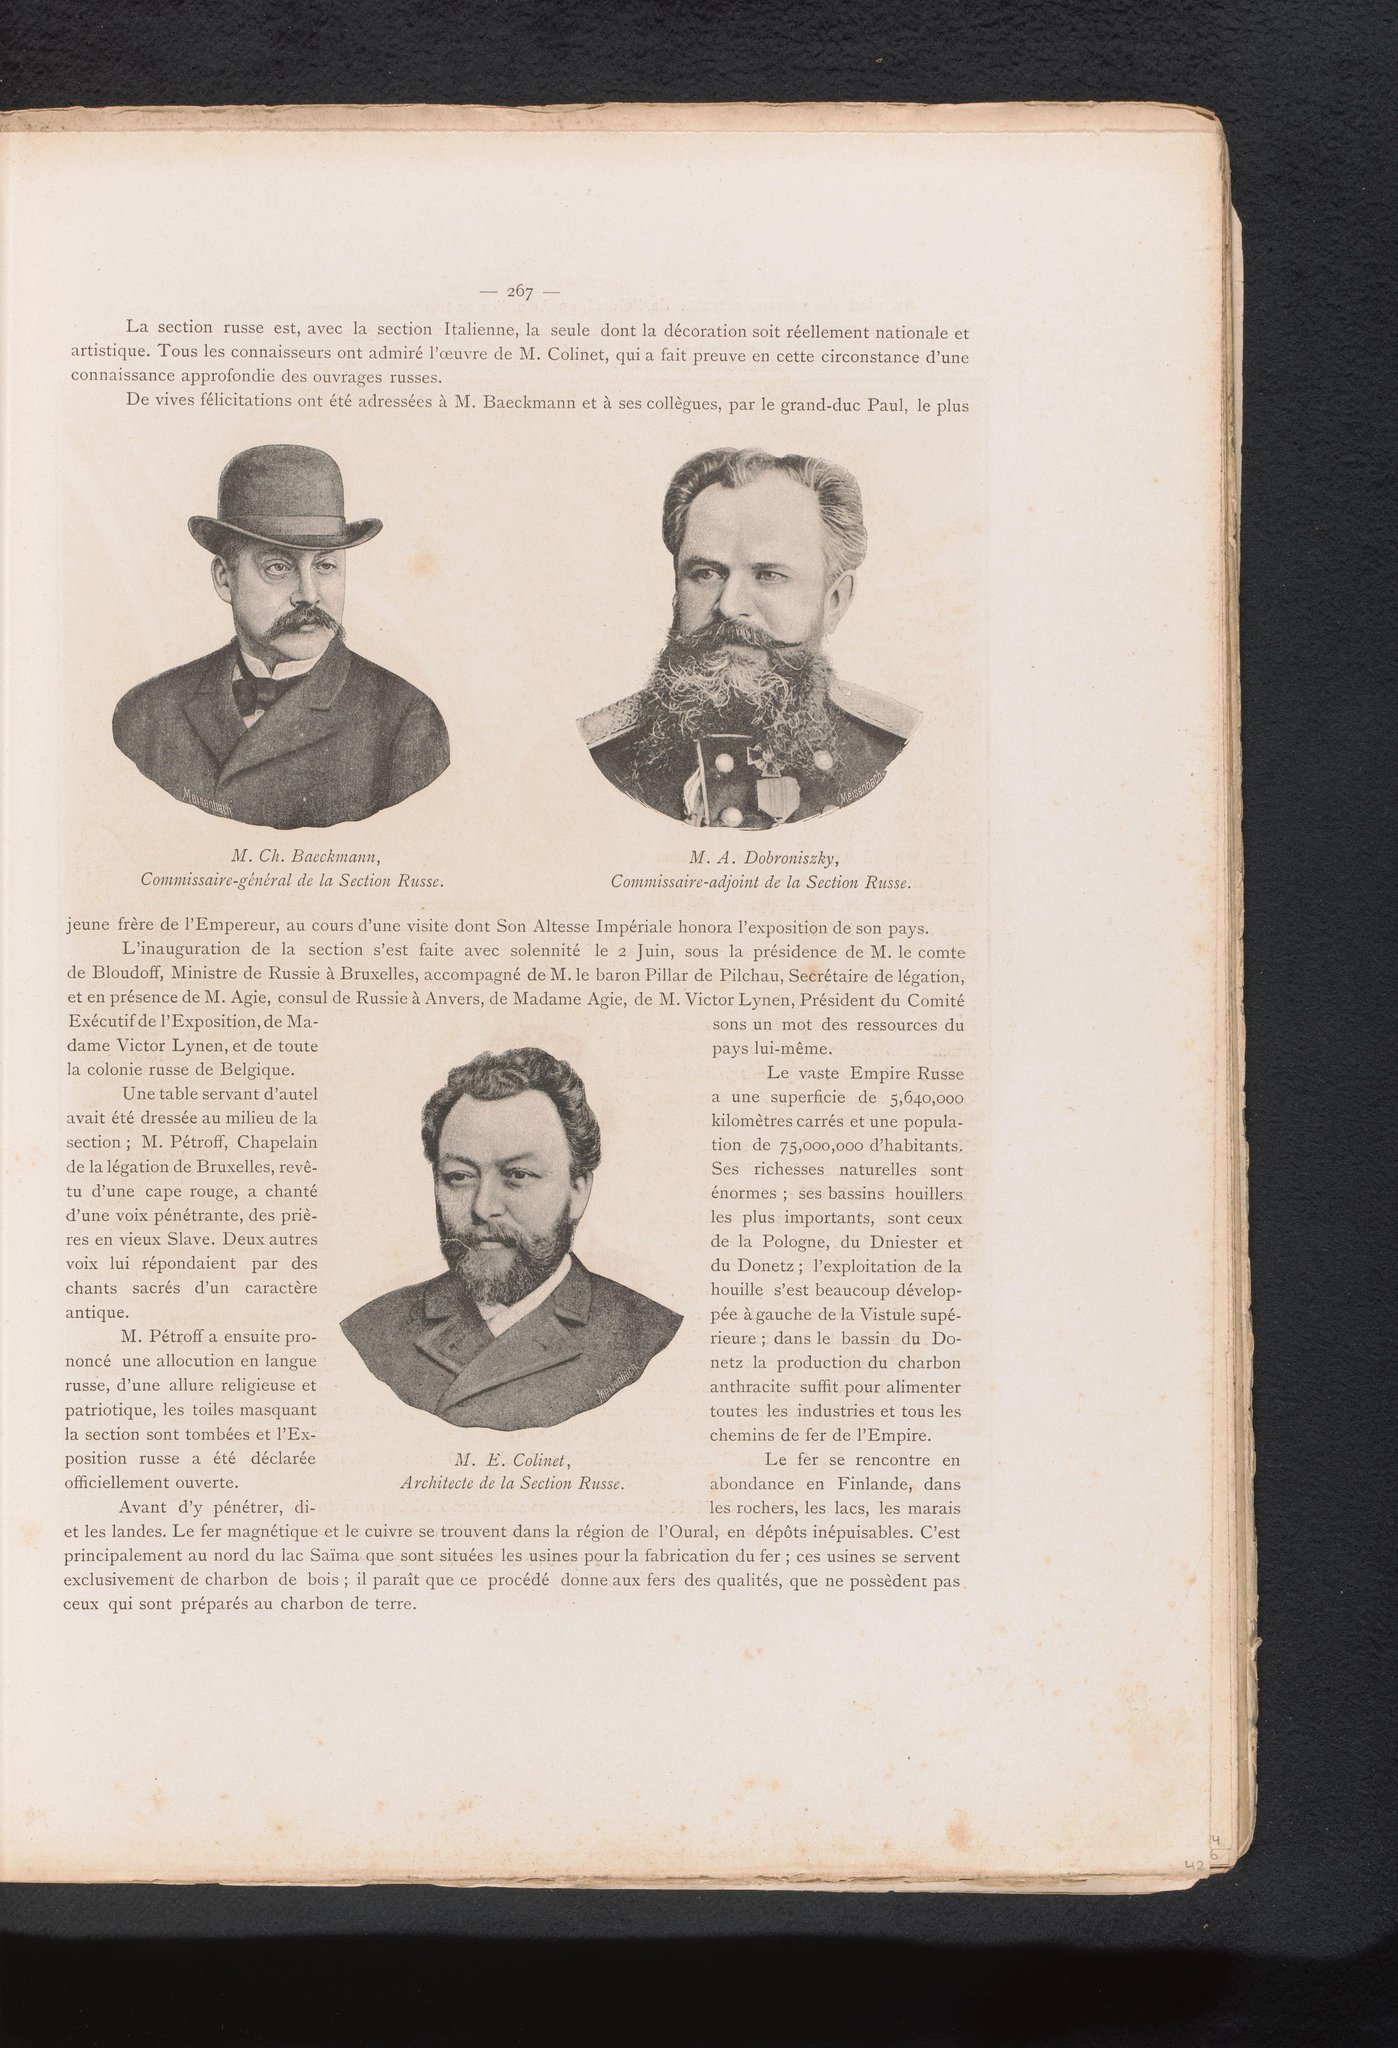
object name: photomechanical print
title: Portret van tsaar Alexander III van Rusland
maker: Anonymous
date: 1880-1885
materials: paper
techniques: autotype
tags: historical persons, emperor